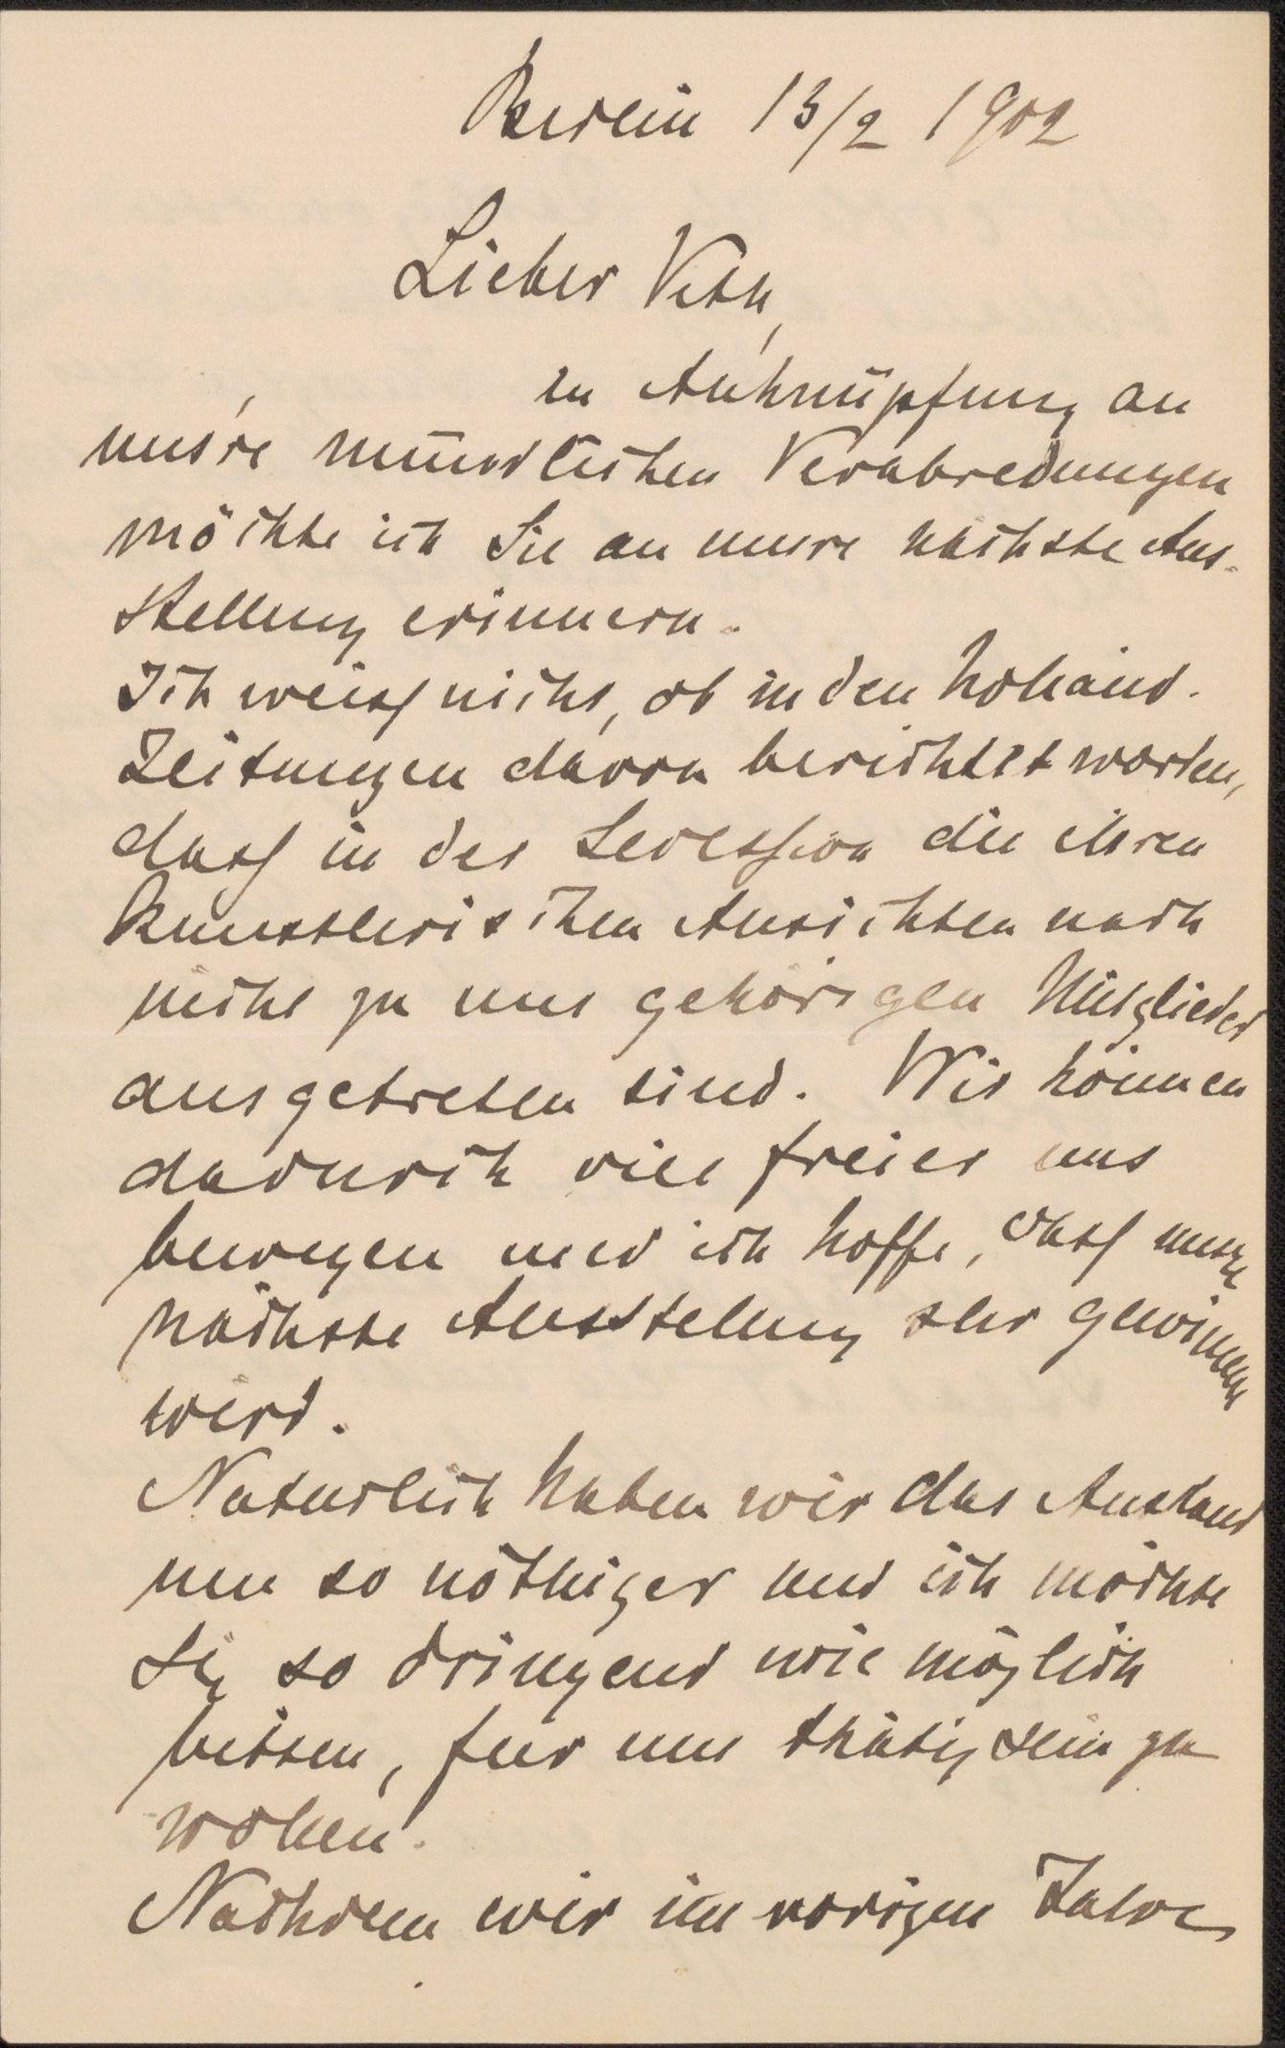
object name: letter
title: Brief aan Jan Veth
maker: max liebermann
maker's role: draughtsman, print maker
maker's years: 1847-1935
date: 1902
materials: ink, paper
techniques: pen, writing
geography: berlin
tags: rotterdam, amsterdam, painter, george hendrik breitner, dordrecht, designer, jan veth, isaac israels, utrecht, etha fles, jan toorop, klaas groesbeek, exhibition ~ art, historical persons (portraits and scenes from the life)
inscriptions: watermark, collector's mark: ‘RPK’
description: Opgenomen in: Ernst Braun, Max Liebermann: Briefe 1902-1906, Baden-Baden: Deutscher Wissenschafts-Verlag, 2013, Band 3, p. 24-25.